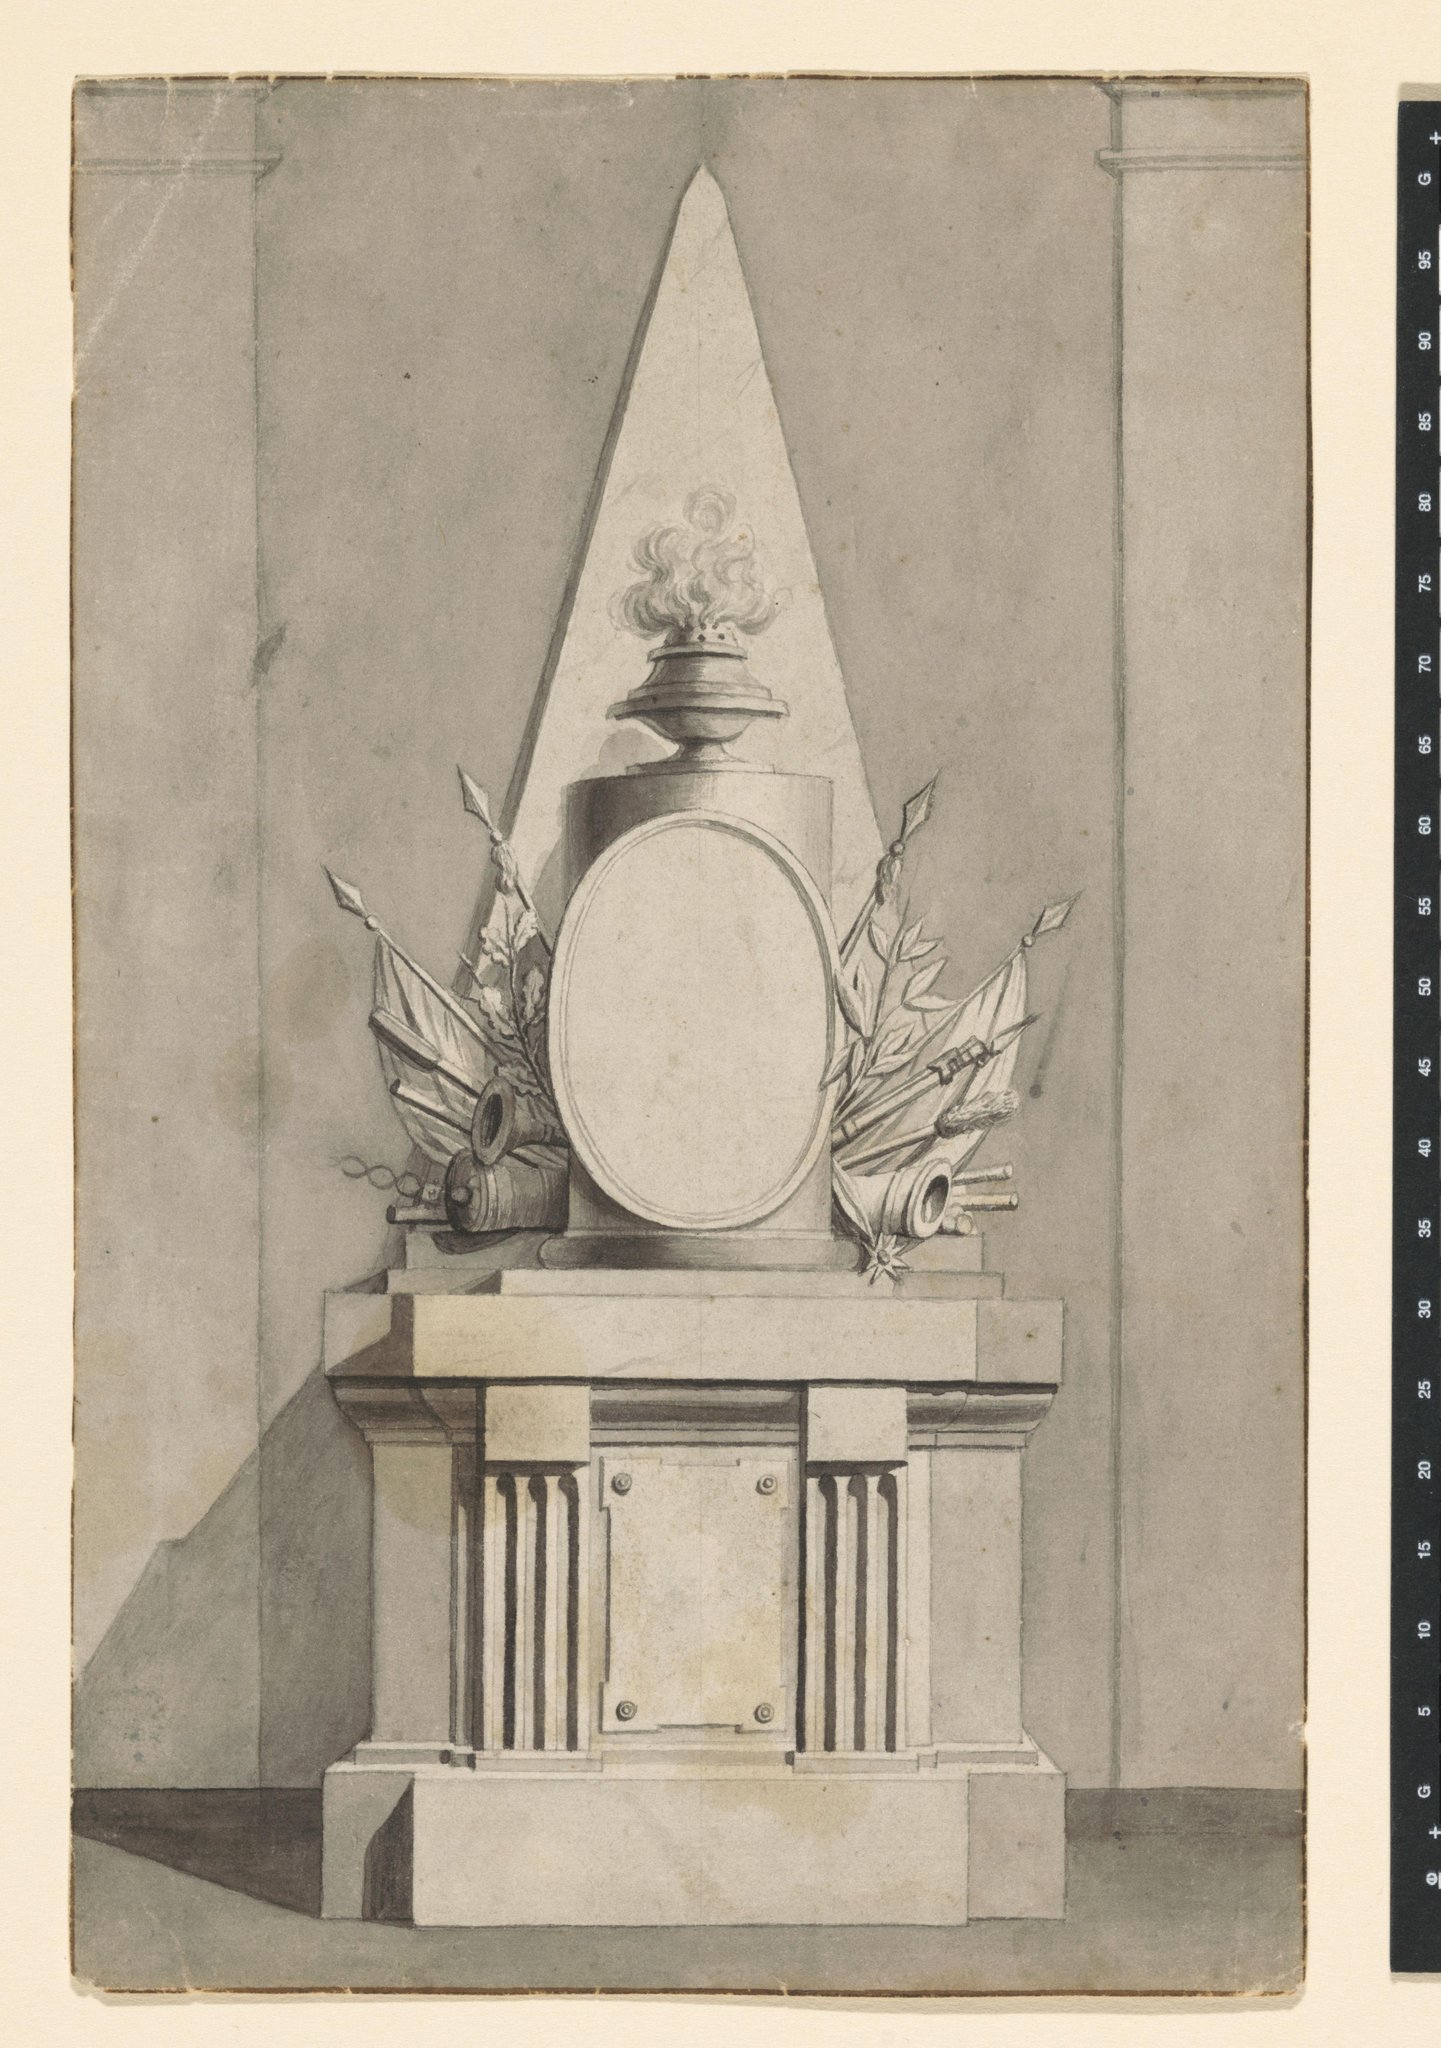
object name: drawing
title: Grafmonument met obelisk en medaillon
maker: Anonymous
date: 1650-1800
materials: ink, paper, pencil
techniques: brush, pen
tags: ornament ~ medallion, grave, tomb, needle, obelisk (marking grave)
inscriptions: collector's mark: Lugt 2228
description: Een grafmonument met een obelisk, een ovaal medaillon, vlaggen, wapens en een rookvat.